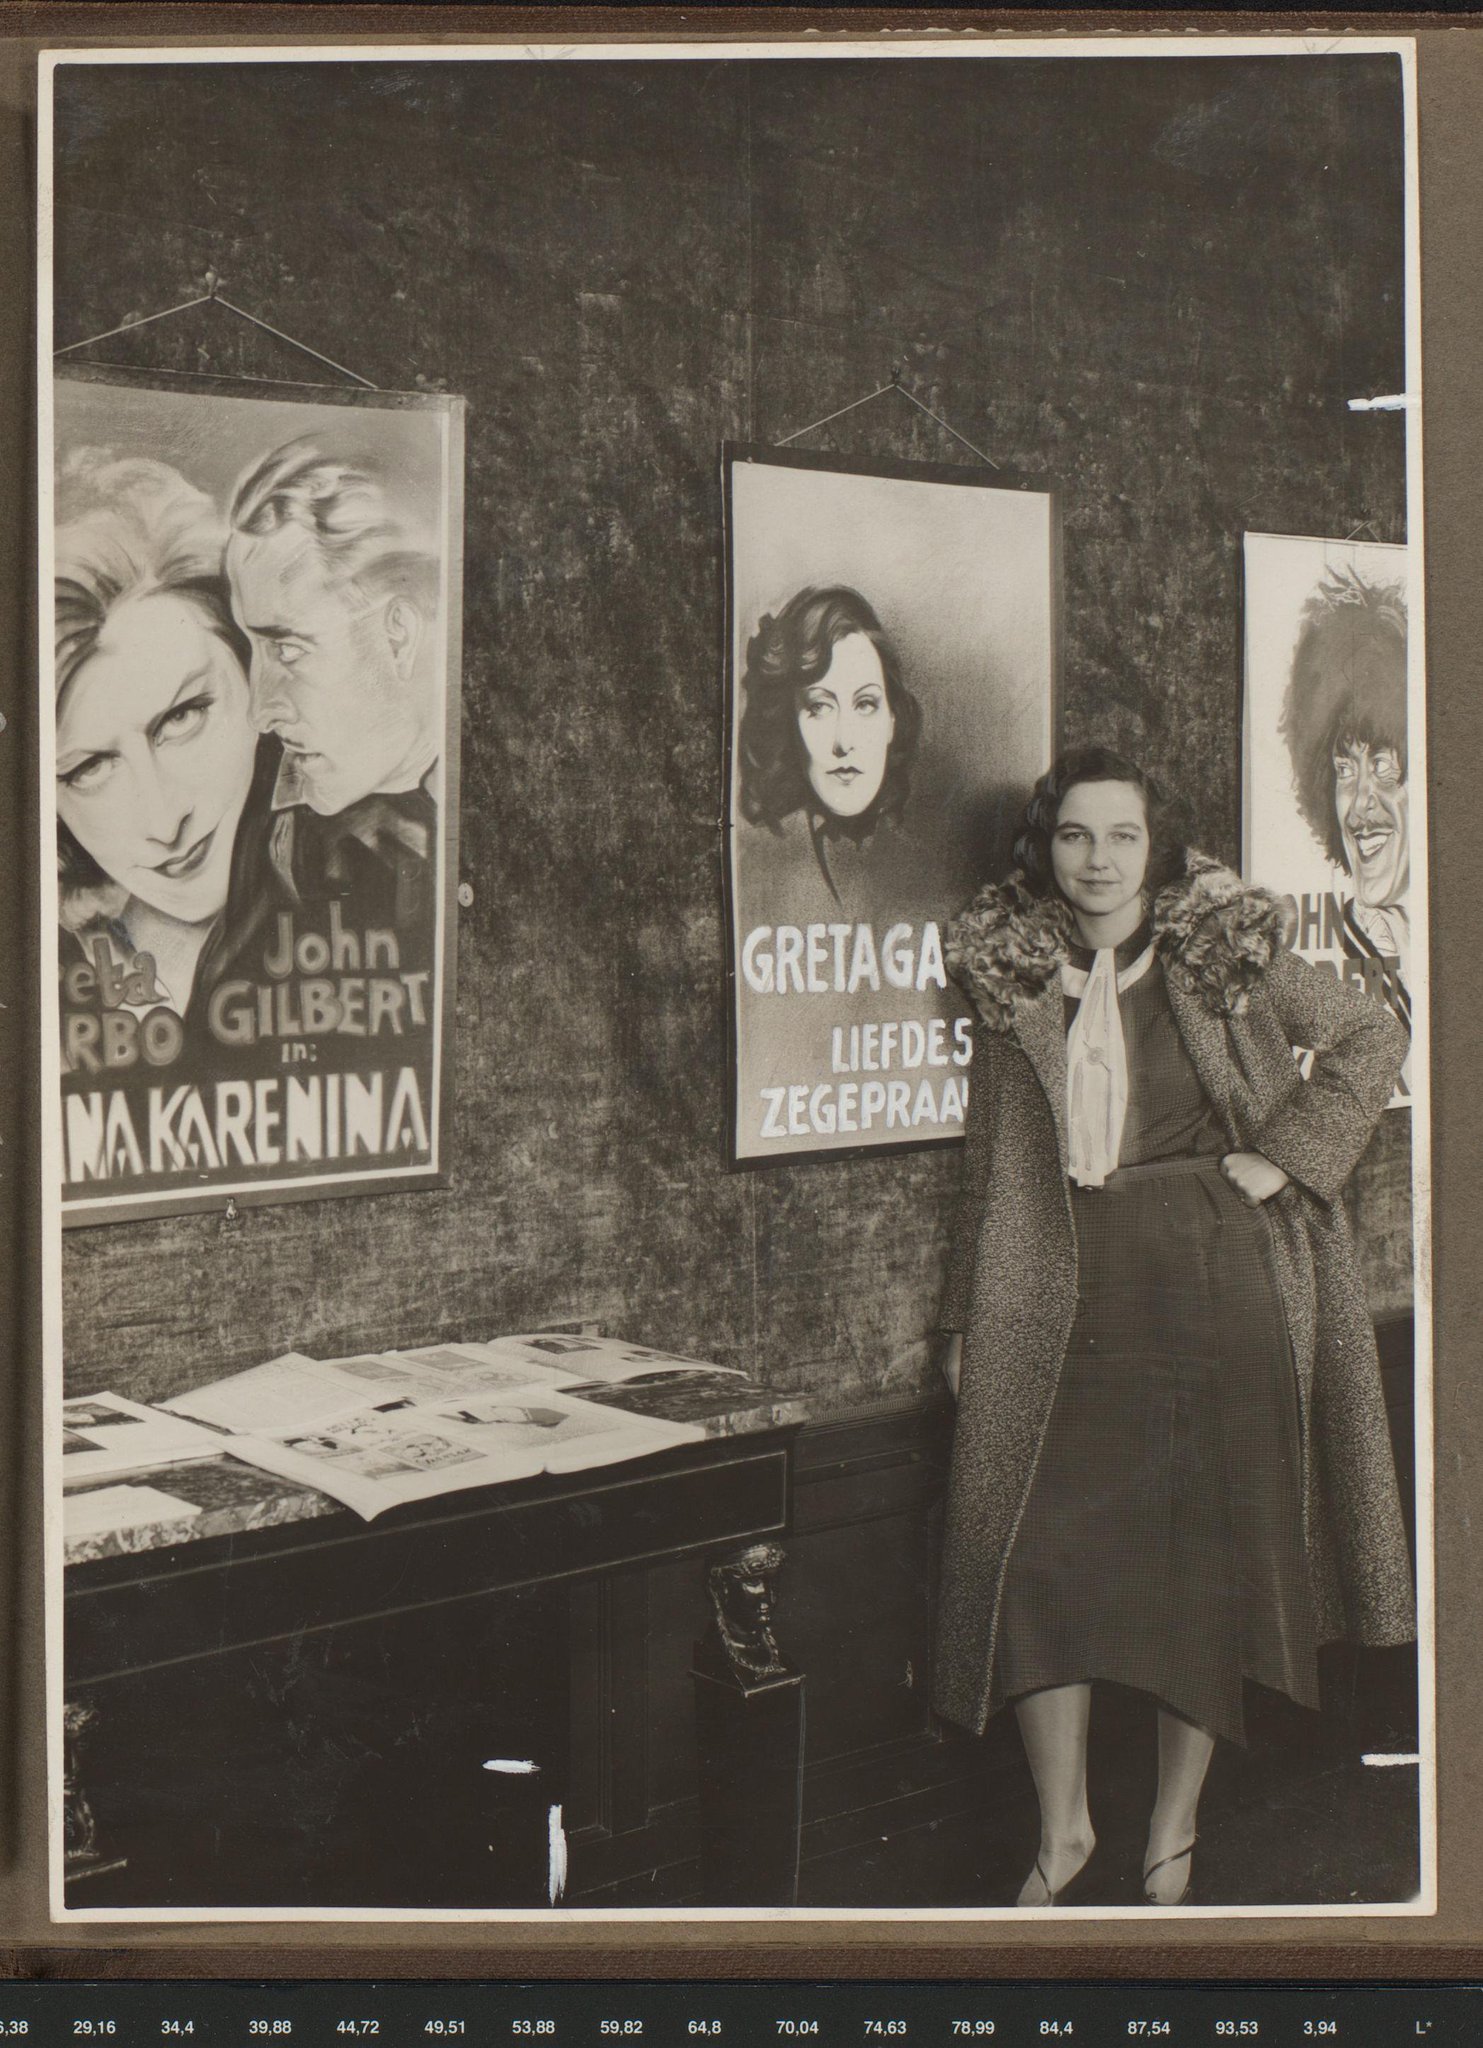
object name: photograph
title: Dolly Rudeman op een tentoonstelling met haar werk in Kunstzaal Kleijkamp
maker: Anonymous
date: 1931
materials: paper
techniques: gelatin silver print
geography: the hague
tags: amsterdam, painter, draughtsman, designer, historical persons - bb - woman, collection, exhibition, show, poster, the hague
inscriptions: inscription: ‘Dolly Rudeman’